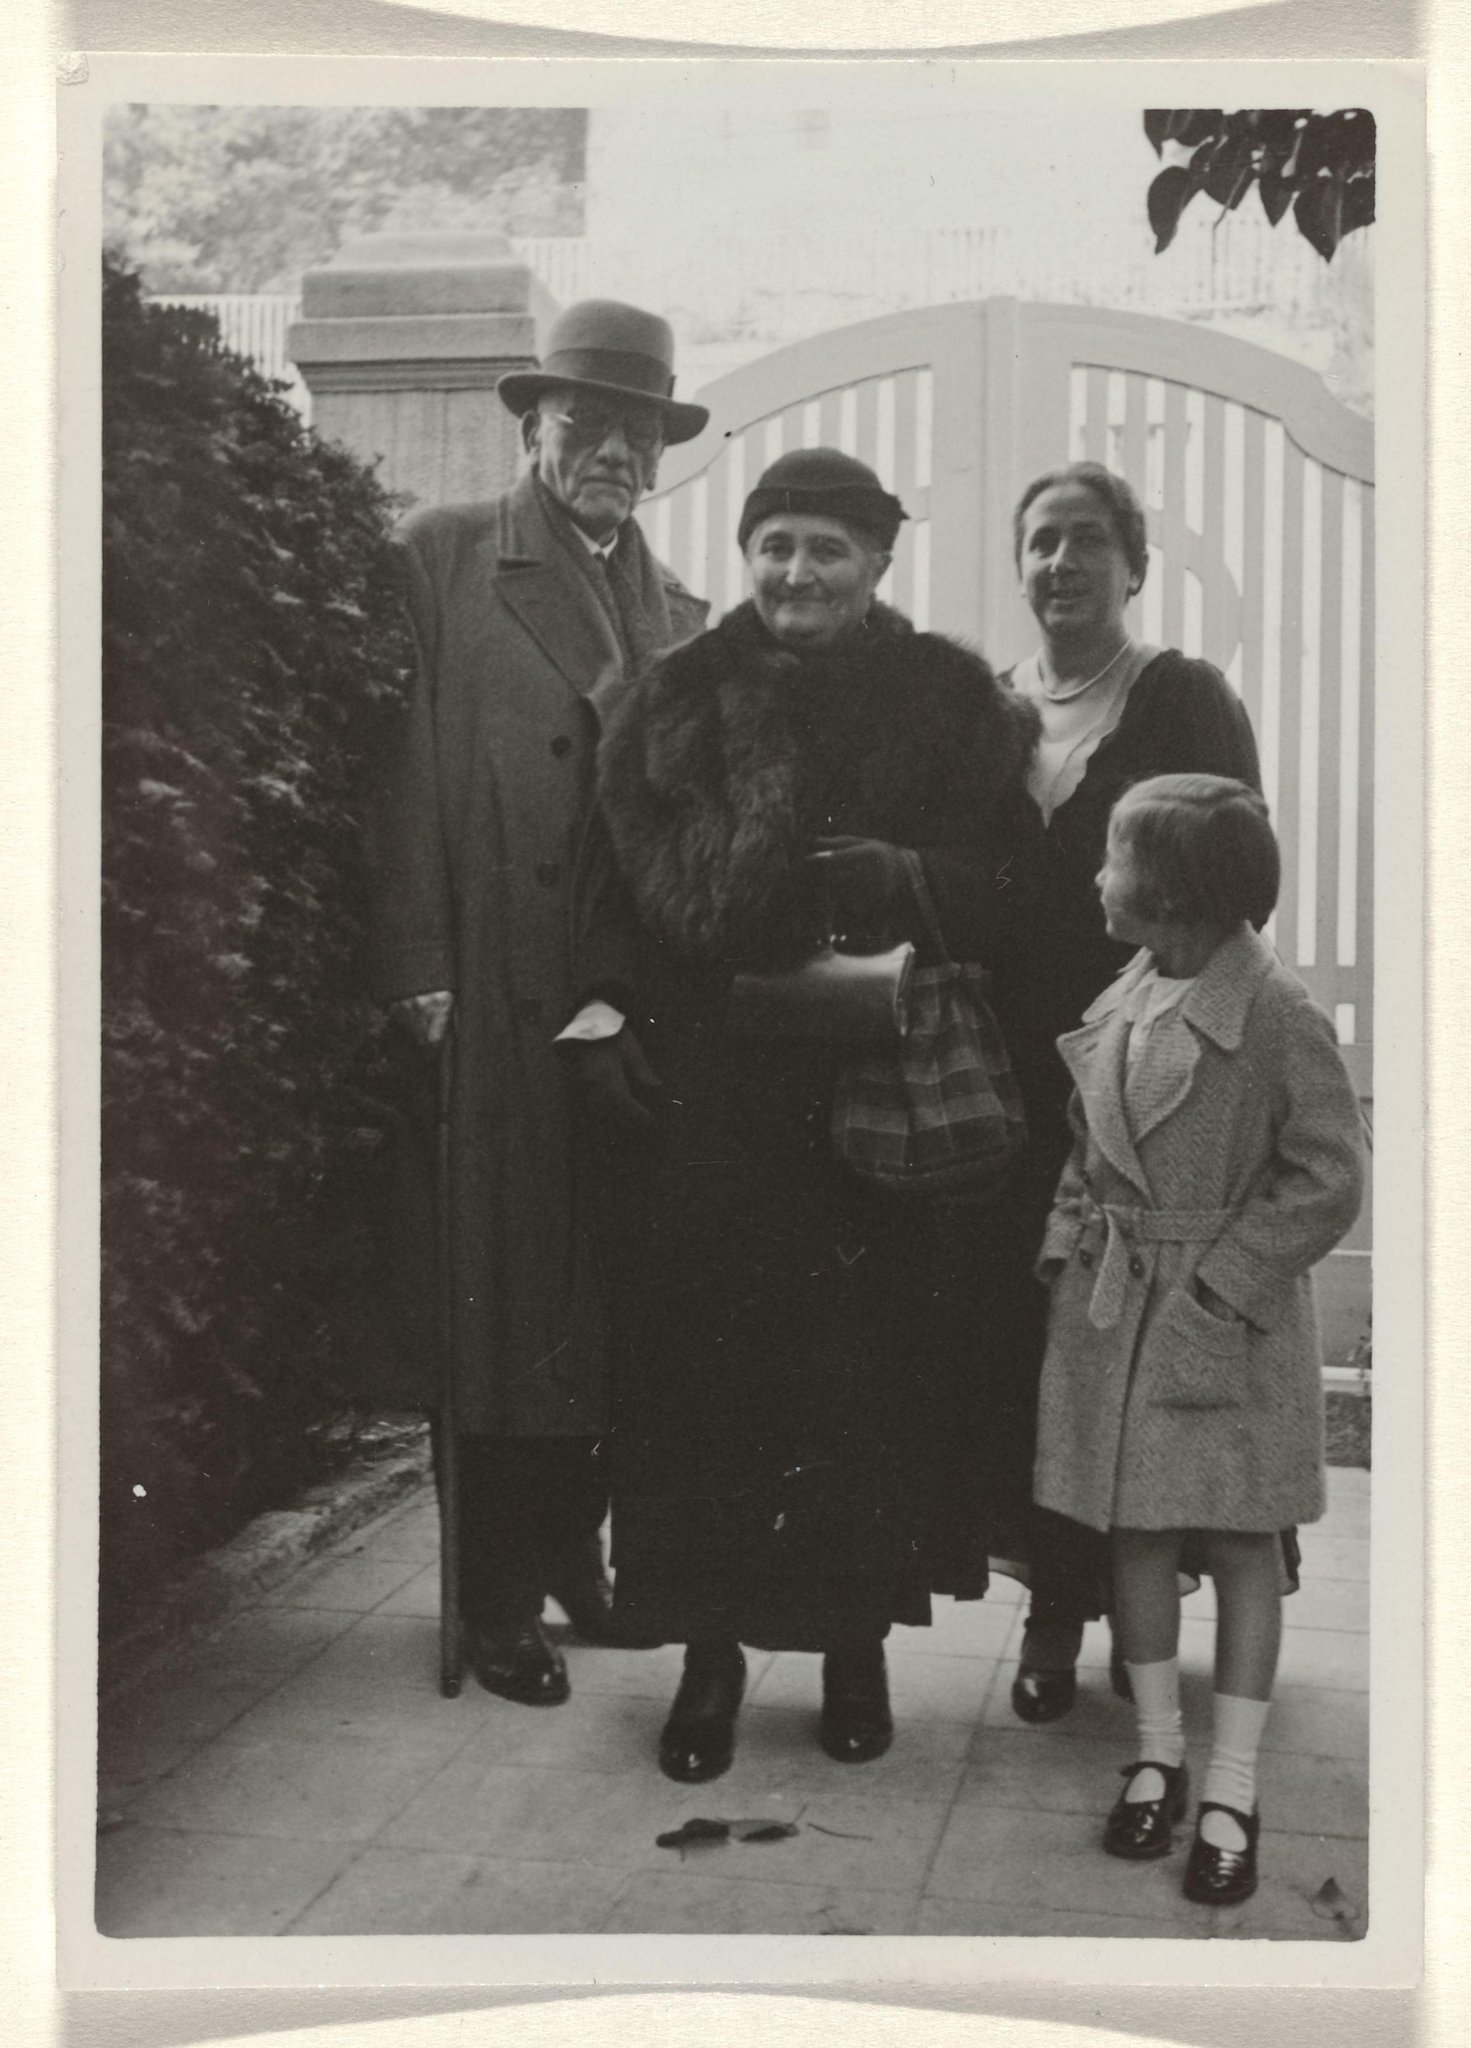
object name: photograph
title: Meir Wachenheimer, Mathilde Wachenheimer Moos, Else Wachenheimer en Isabel Wachenheimer op gouden huwelijksjubileum Meir en Mathilde, 22 oktober 1934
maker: Anonymous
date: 1934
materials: photographic support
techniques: gelatin silver print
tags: else wachenheimer-moos, leiden, isabel wachenheimer-elon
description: Dit object is onderdeel van de nalatenschap van Isabel Elon-Wachenheimer (1928-2010). Tot haar overlijden behoorde het samen met de andere objecten uit de nalatenschap tot haar privédomein van Isabel Wachenheimer. In die particuliere context zijn deze objecten tezamen en individueel aandenkens - aan de jeugd, ouders en familie van Isabel Wachenheimer vóór en tijdens de Shoah en aan haar leven na de Tweede Wereldoorlog. Isabel Wachenheimer, die van juni 1943 tot mei 1945 gevangen zat in Kamp Westerbork, Theresienstadt, Auschwitz, Lenzing a/d Oberdonau (een buitenkamp van Mauthausen), overleefde de Shoah. Haar ouders – Eugène Wachenheimer en Else Wachenheimer-Moos - werden op 14 oktober 1944 in Auschwitz-Birkenau vermoord.